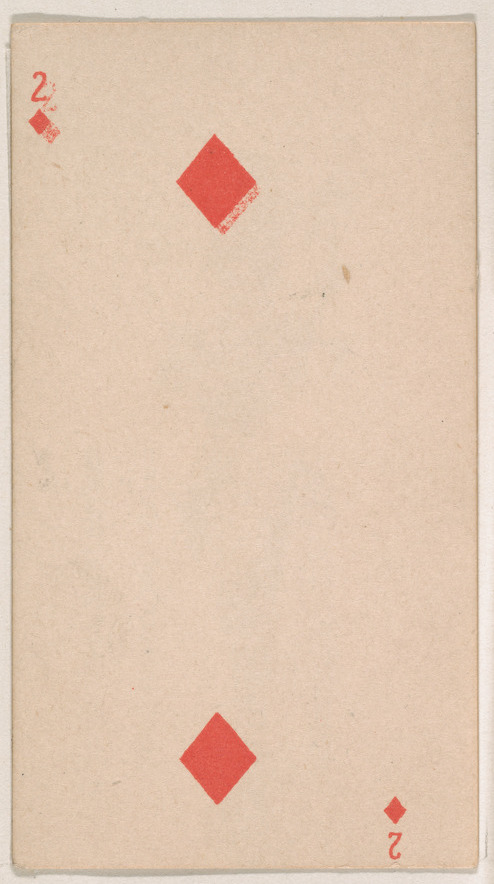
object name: print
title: Two of Diamonds, from the Transparent Playing Cards series (N220) issued by Kinney Bros.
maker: kinney brothers tobacco company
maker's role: publisher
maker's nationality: american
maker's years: 1869-2011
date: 1888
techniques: color lithograph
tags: playing cards